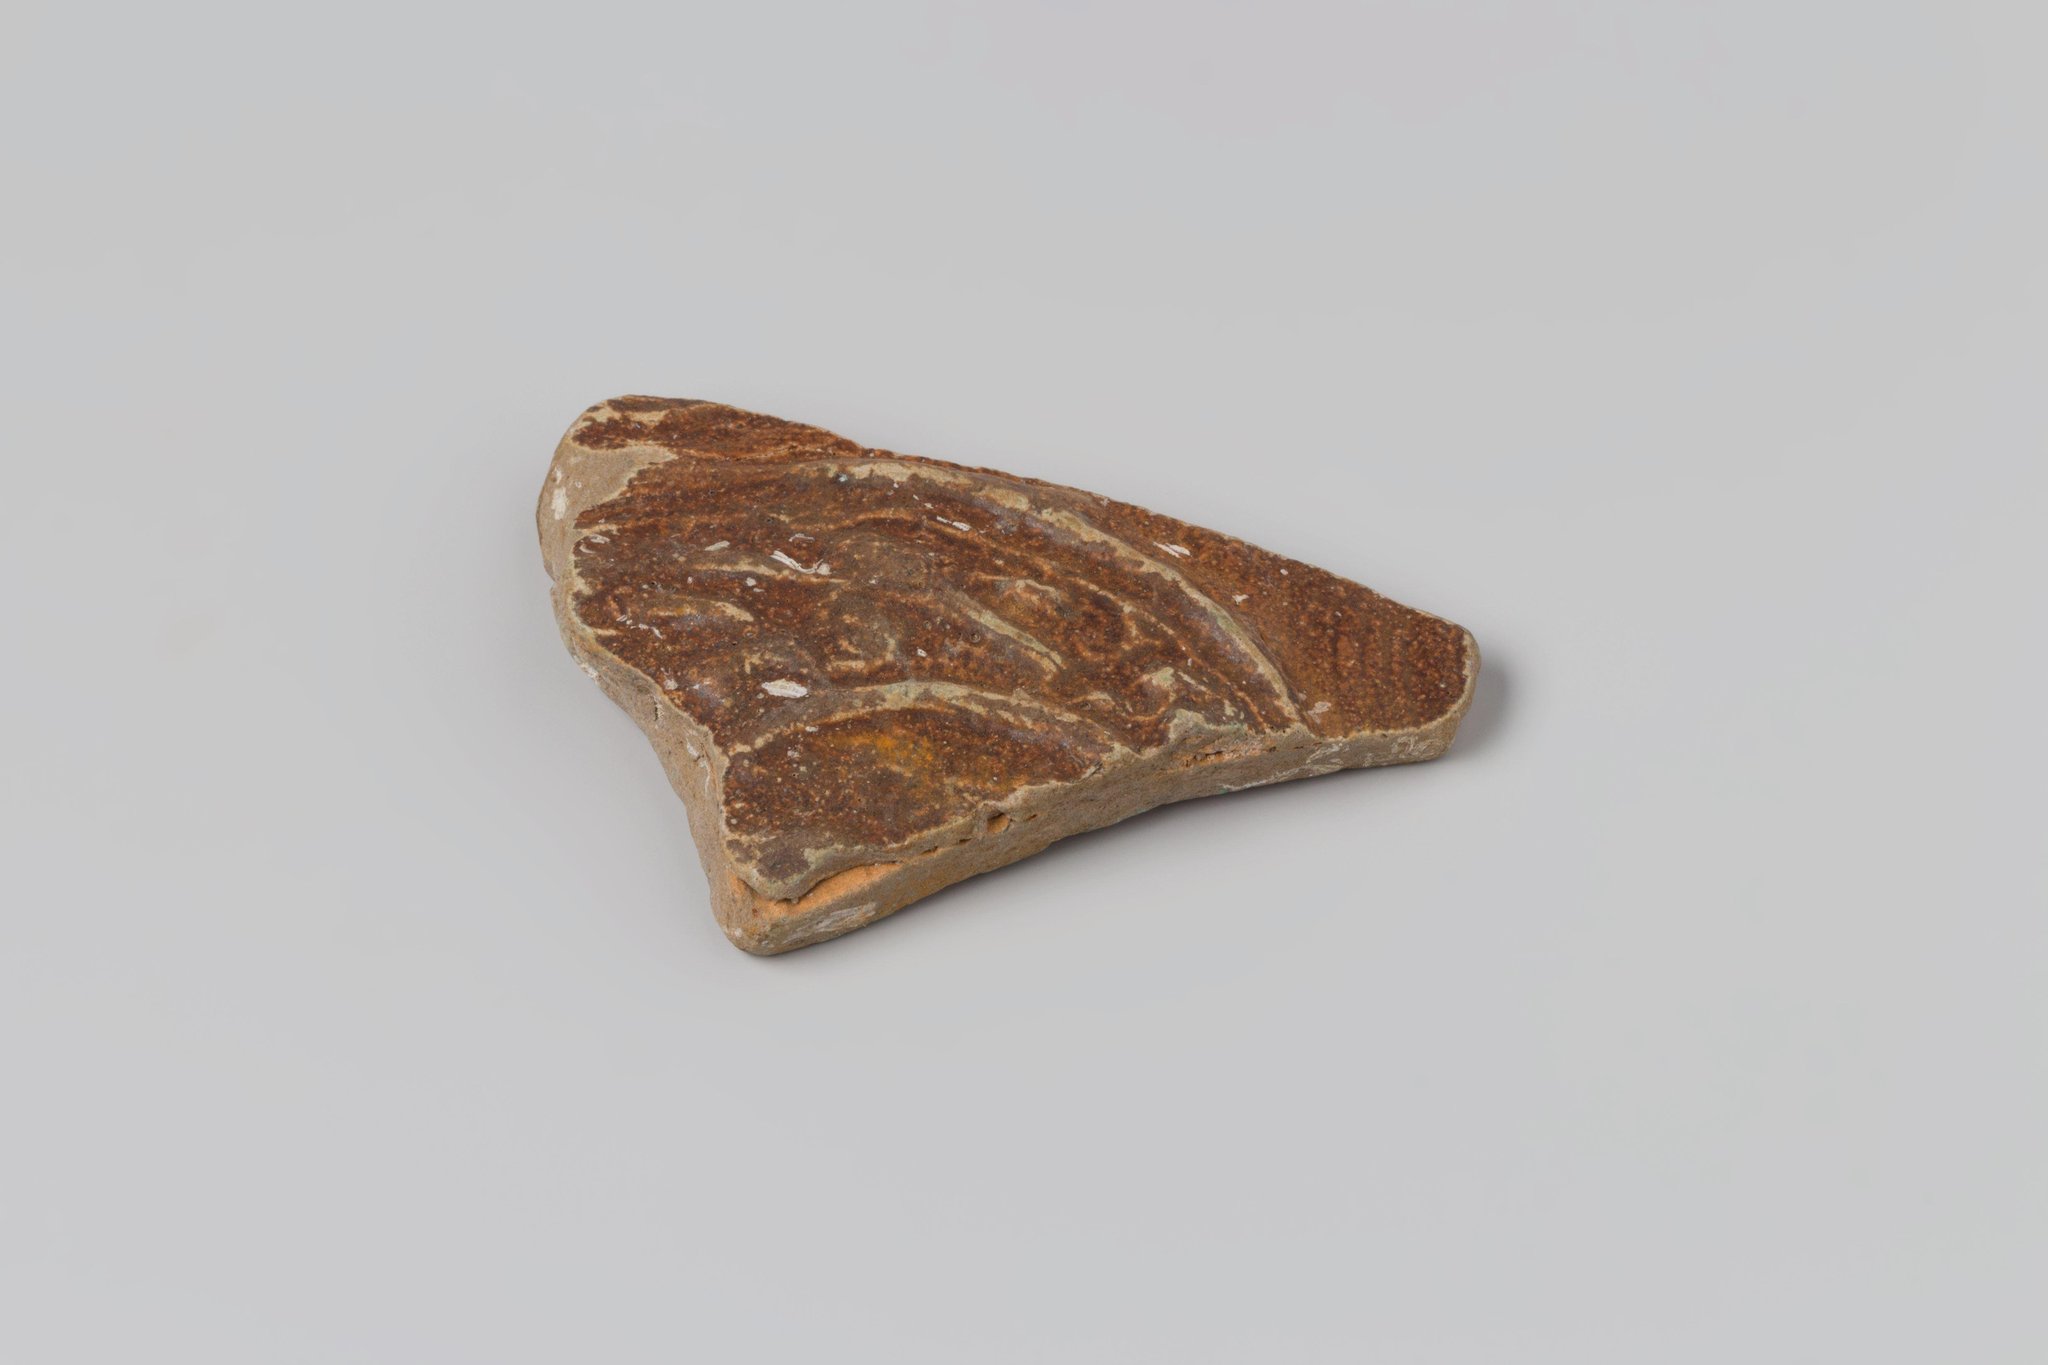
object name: storage jar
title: Scherf van een voorraadpot uit het wrak van de Oost-Indiëvaarder Hollandia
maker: Anonymous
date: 1700-1743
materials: stoneware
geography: cologne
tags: verenigde oostindische compagnie, hollandia (schip), annet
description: Stoneware, Rhenish, Langerwehe-ware, storage-jar; fragm of body with medallion-appliqué, sim. NG 1980-27H909.